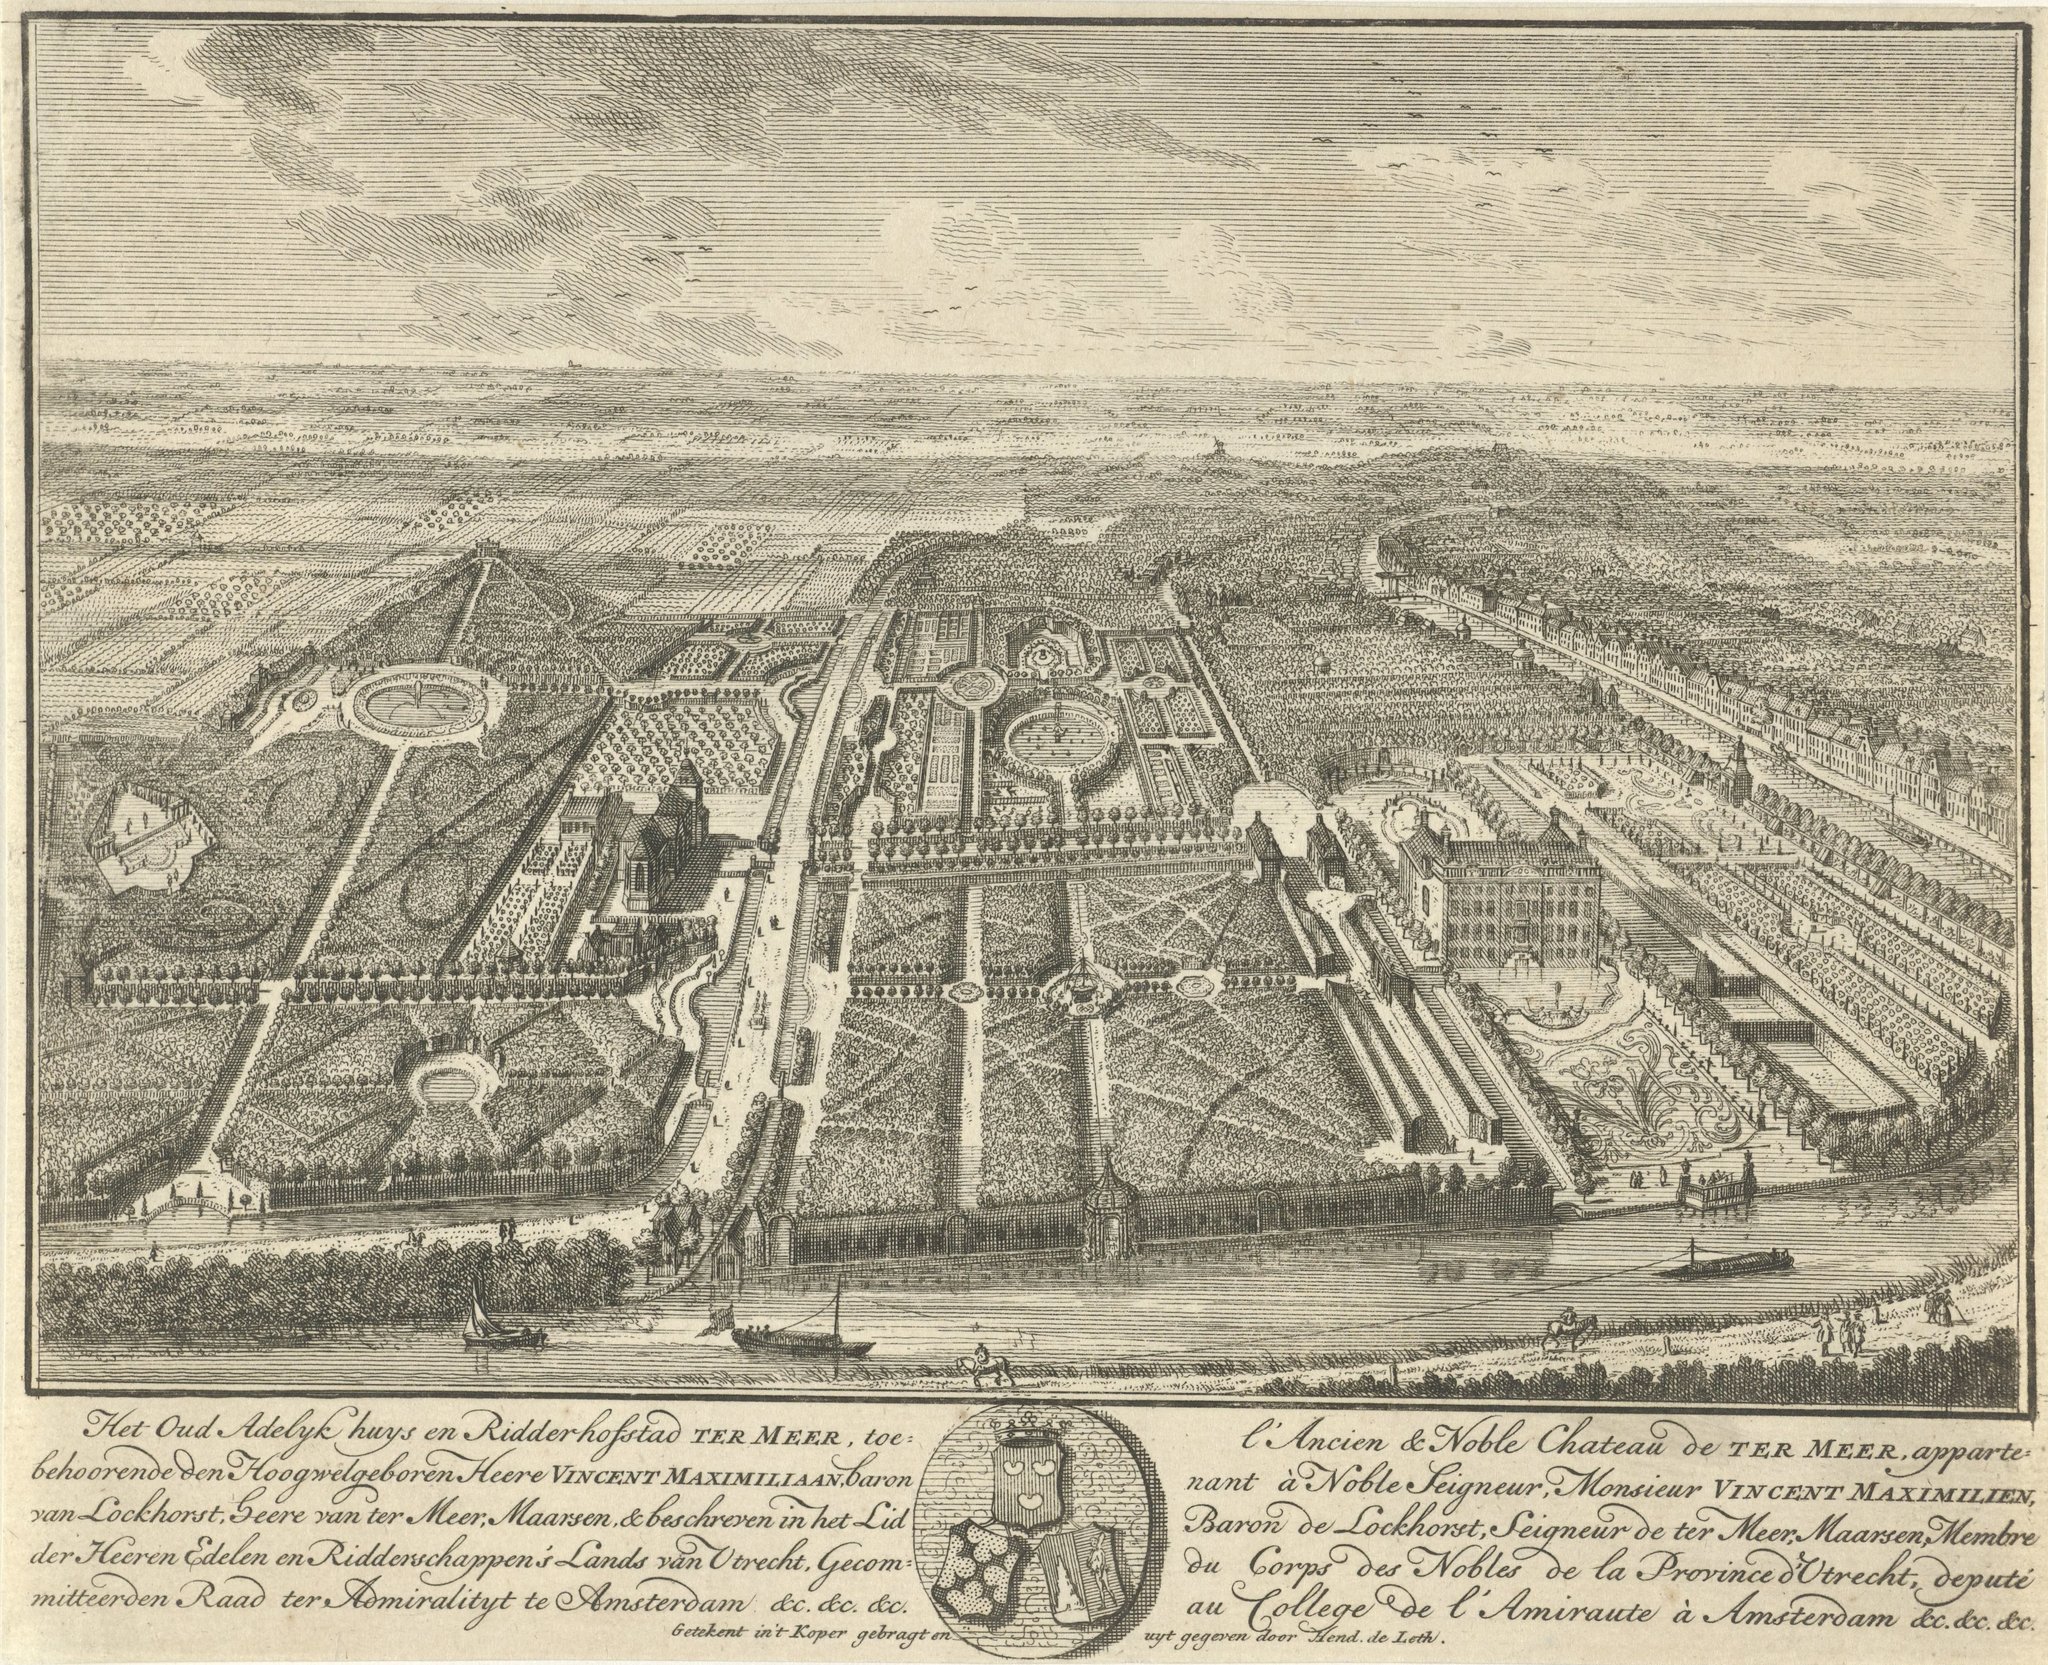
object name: print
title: Het Oud Adelyk huys en Ridderhofstad Ter Meer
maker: hendrik de leth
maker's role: draughtsman, print maker, publisher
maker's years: 1703-1766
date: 1740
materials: paper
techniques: etching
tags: french or architectonic garden; formal garden, country-house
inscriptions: collector's mark: Lugt 2228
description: Gezicht op Huis ter Meer en de omliggende Franse tuinen in vogelvlucht. In de marge een ovaal met drie wapenschilden, links en rechts een Nederlands en Frans onderschrift. De prent maakt deel uit van een serie met 26 gezichten op Huis ter Meer en het bijbehorende landgoed te Maarssen.